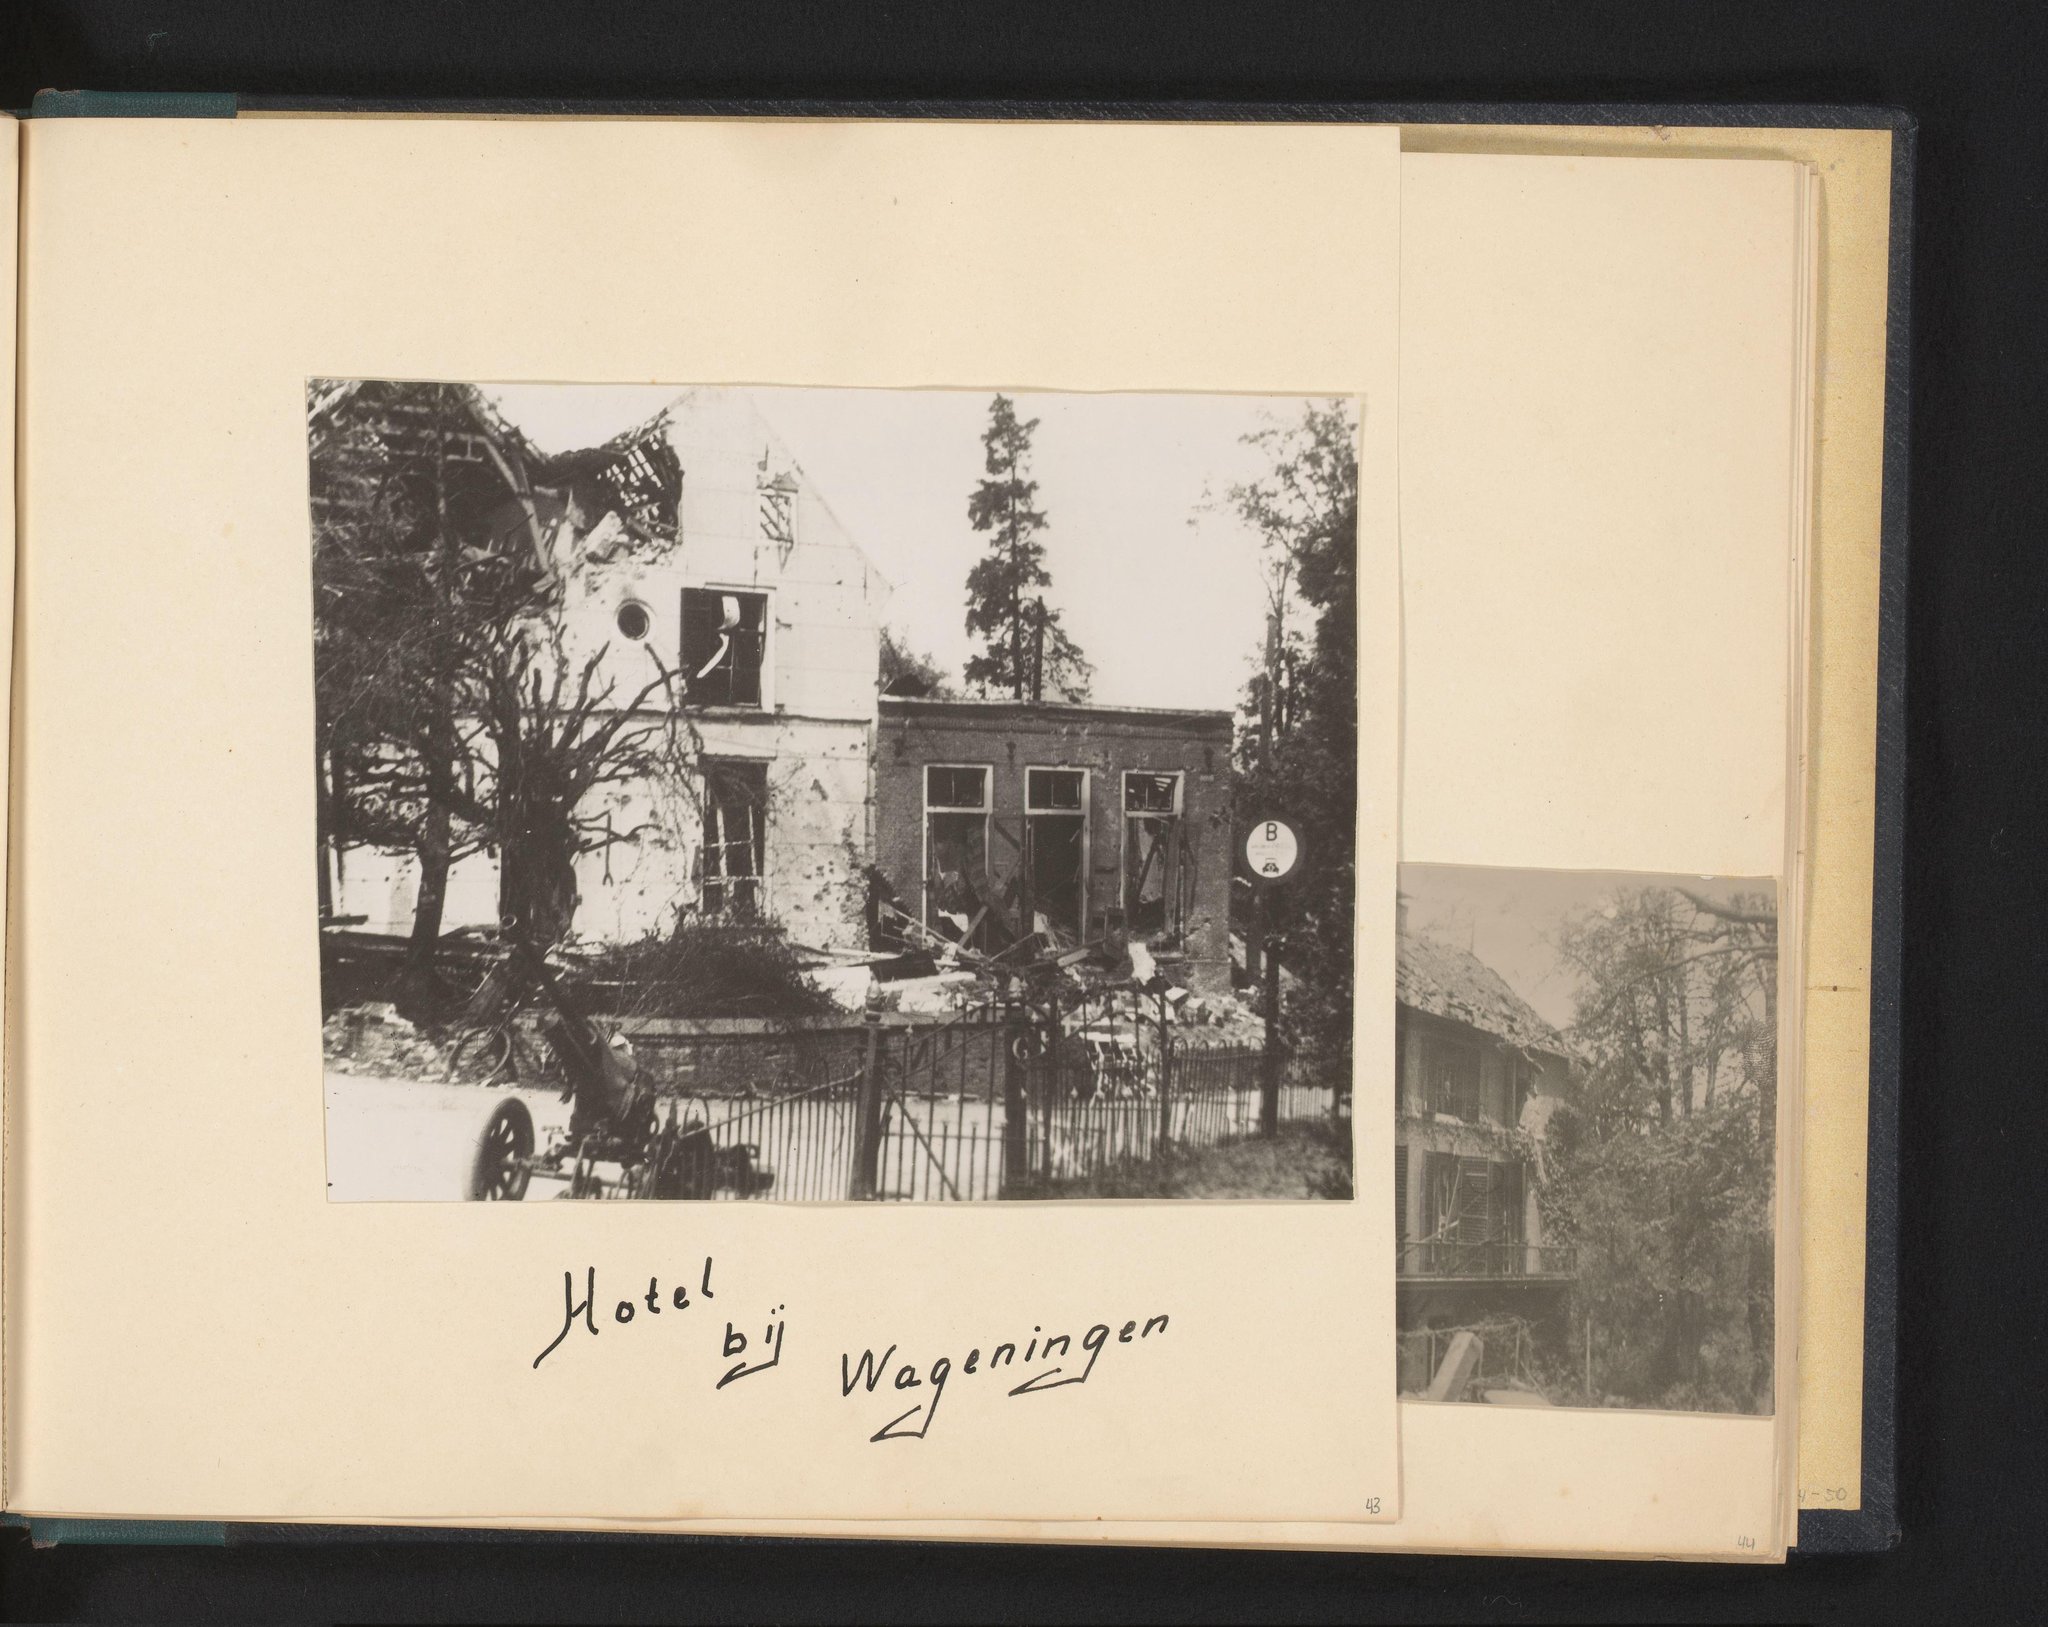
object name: photograph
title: Hotel bij Wageningen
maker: Anonymous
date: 1940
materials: cardboard, photographic support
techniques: gelatin silver print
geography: wageningen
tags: devastated, ruined place or city (~ warfare)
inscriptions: inscription: ‘Hotel bij Wageningen’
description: Albumblad met een foto van een grotendeels verwoest hotel bij Wageningen, waarschijnlijk rond 10 mei 1940. Op straat staat een stuk geschut. Onderdeel van het fotoalbum over de verwoestingen van Nederlandse steden en infrastructuur in het begin van de Tweede Wereldoorlog.